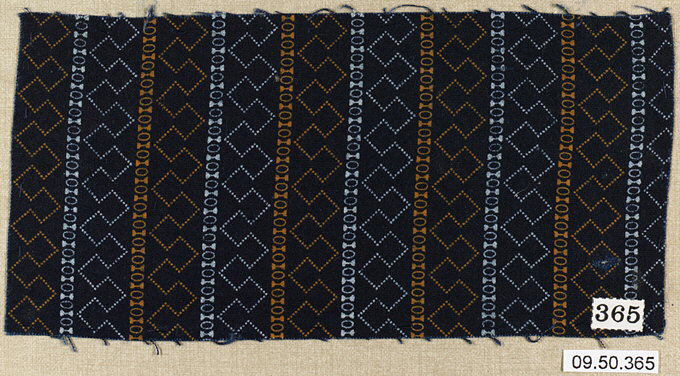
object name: piece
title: Piece (one of 116)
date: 1801-1900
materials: cotton